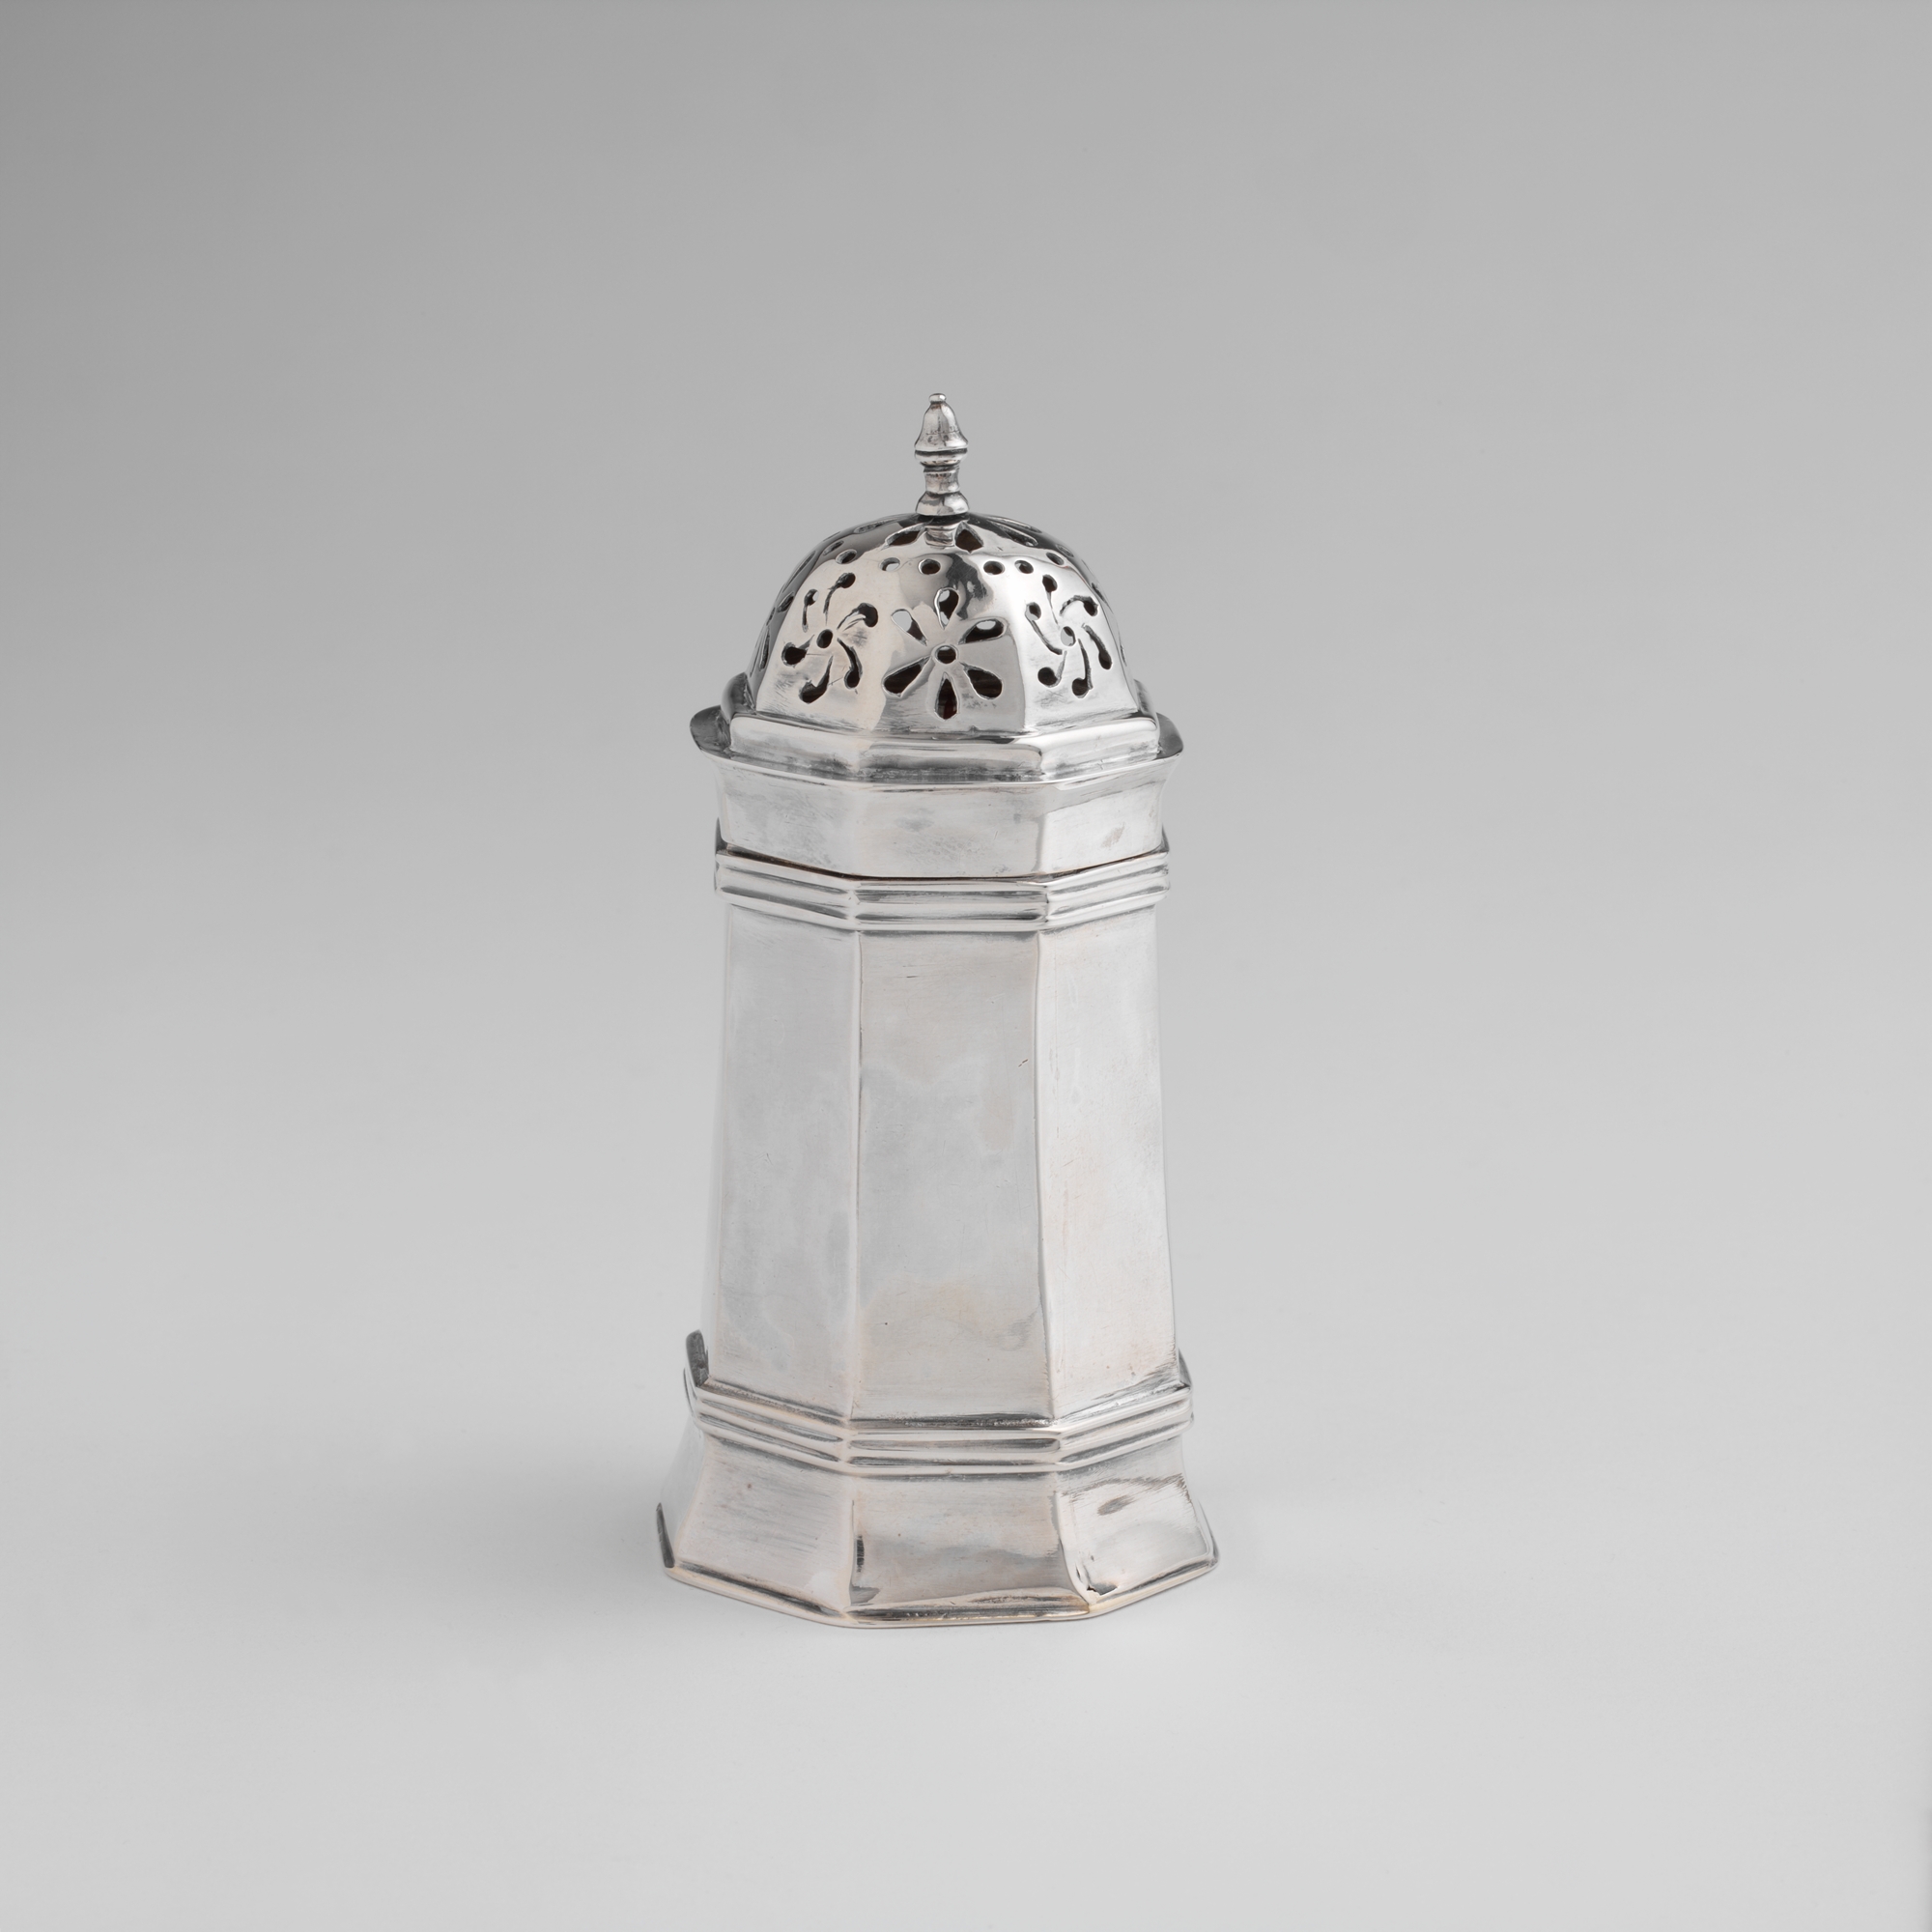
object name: caster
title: Pepper Box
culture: american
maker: jonathan otis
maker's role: maker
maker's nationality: american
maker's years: 1723-1791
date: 1750-1775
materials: silver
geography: united states